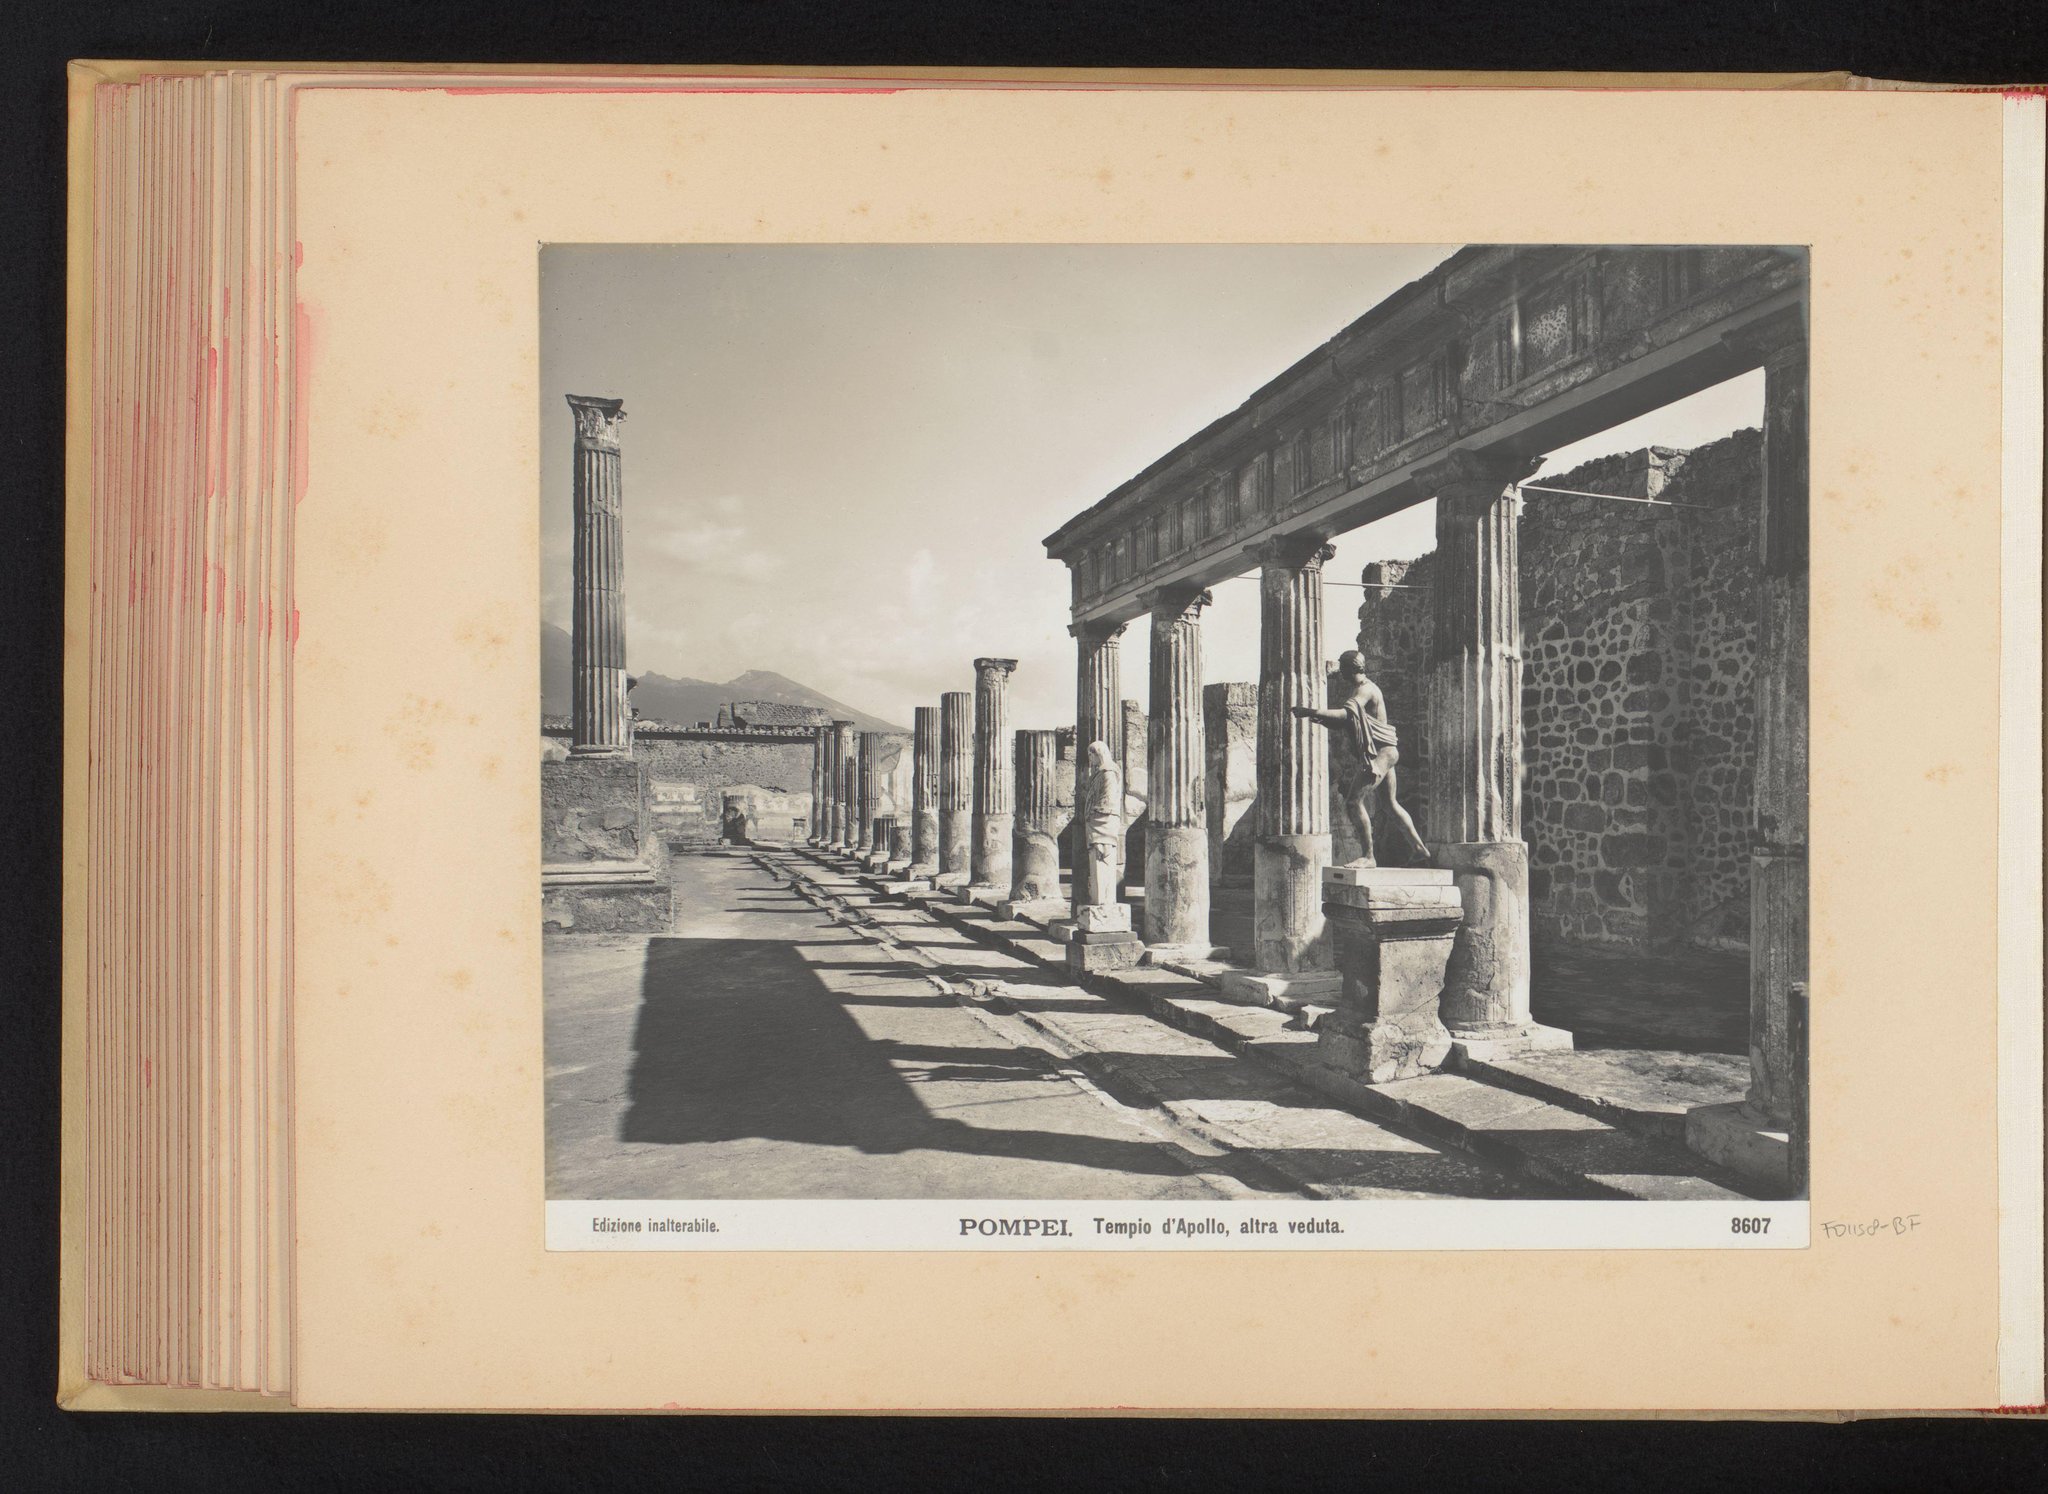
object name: photograph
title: Ruïne van de Tempel van Apollo te Pompeï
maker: Anonymous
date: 1875-1907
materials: photographic support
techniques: gelatin silver print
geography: pompeii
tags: ruin of a building ~ architecture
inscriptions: number: ‘8607’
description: Onderdeel van Fotoalbum met opnames van bezienswaardigheden en kunstwerken in Italië.